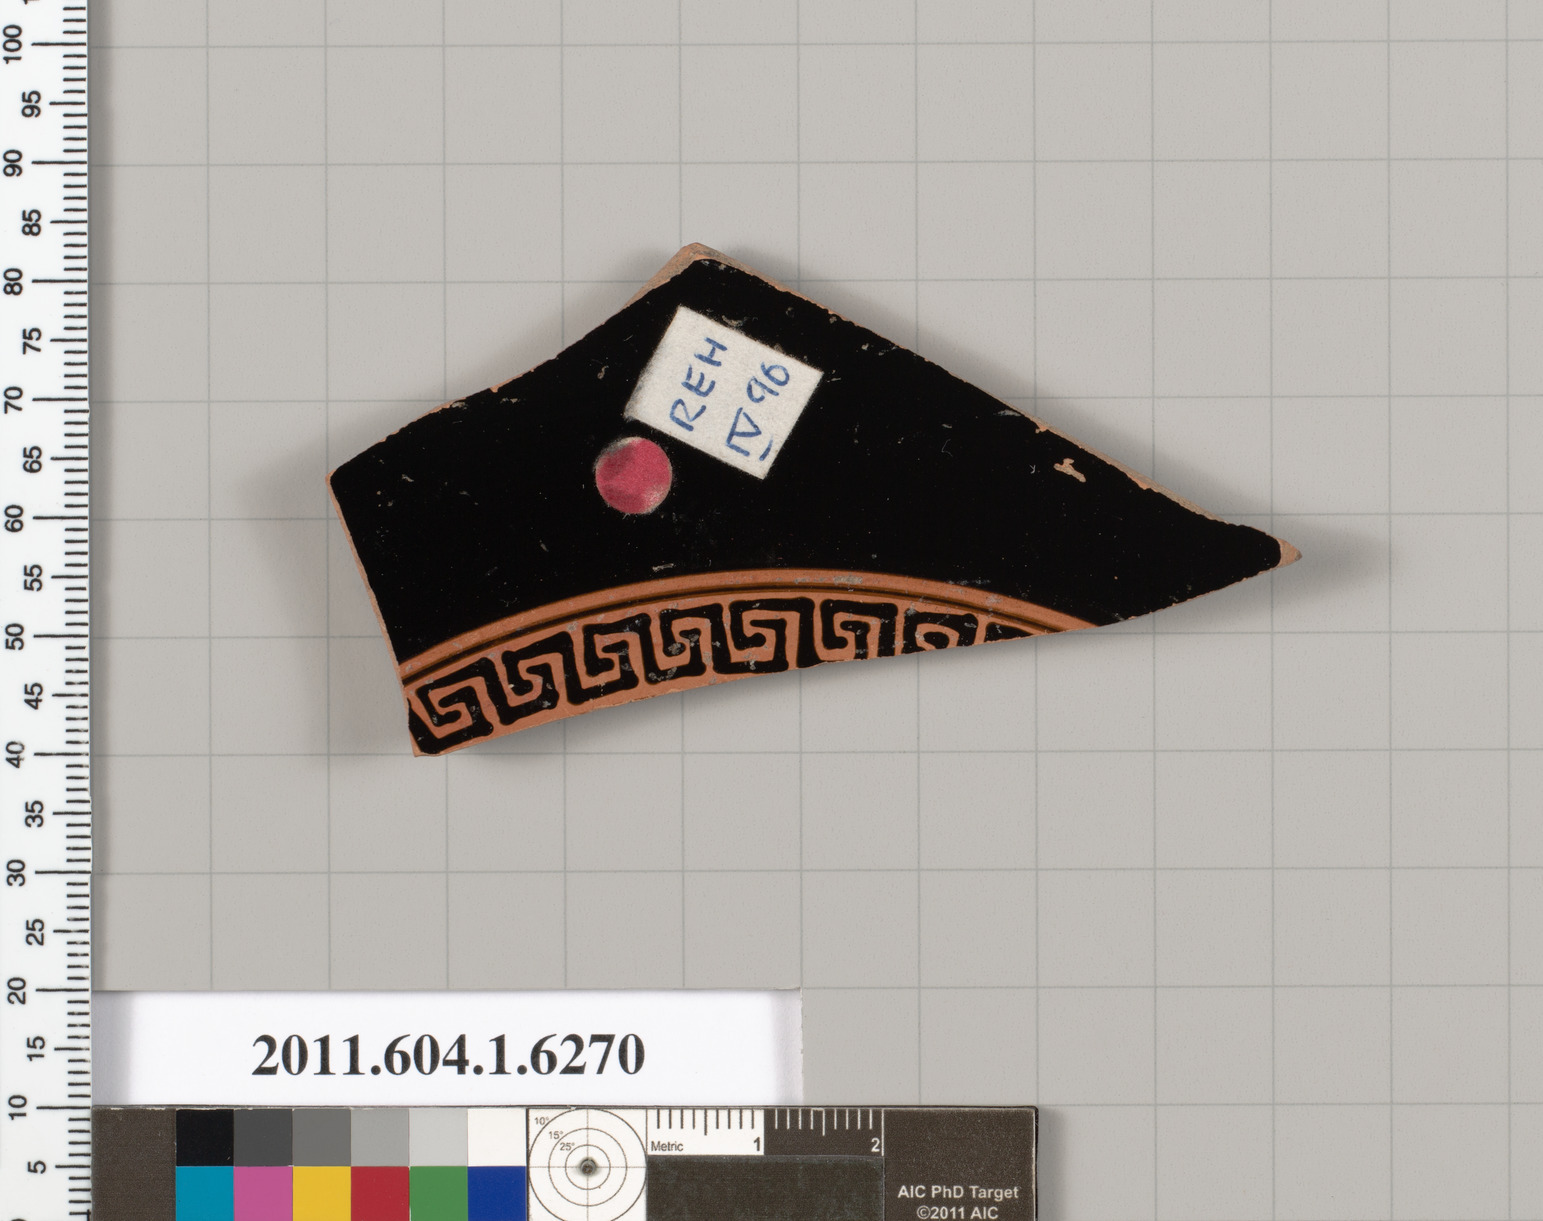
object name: kylix fragment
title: Terracotta fragment of a kylix (drinking cup)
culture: greek, attic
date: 500-480 BCE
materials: terracotta